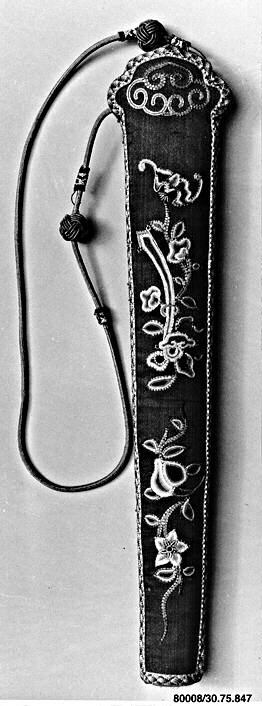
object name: fan holder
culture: chinese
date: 1701-1900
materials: metal thread, silk